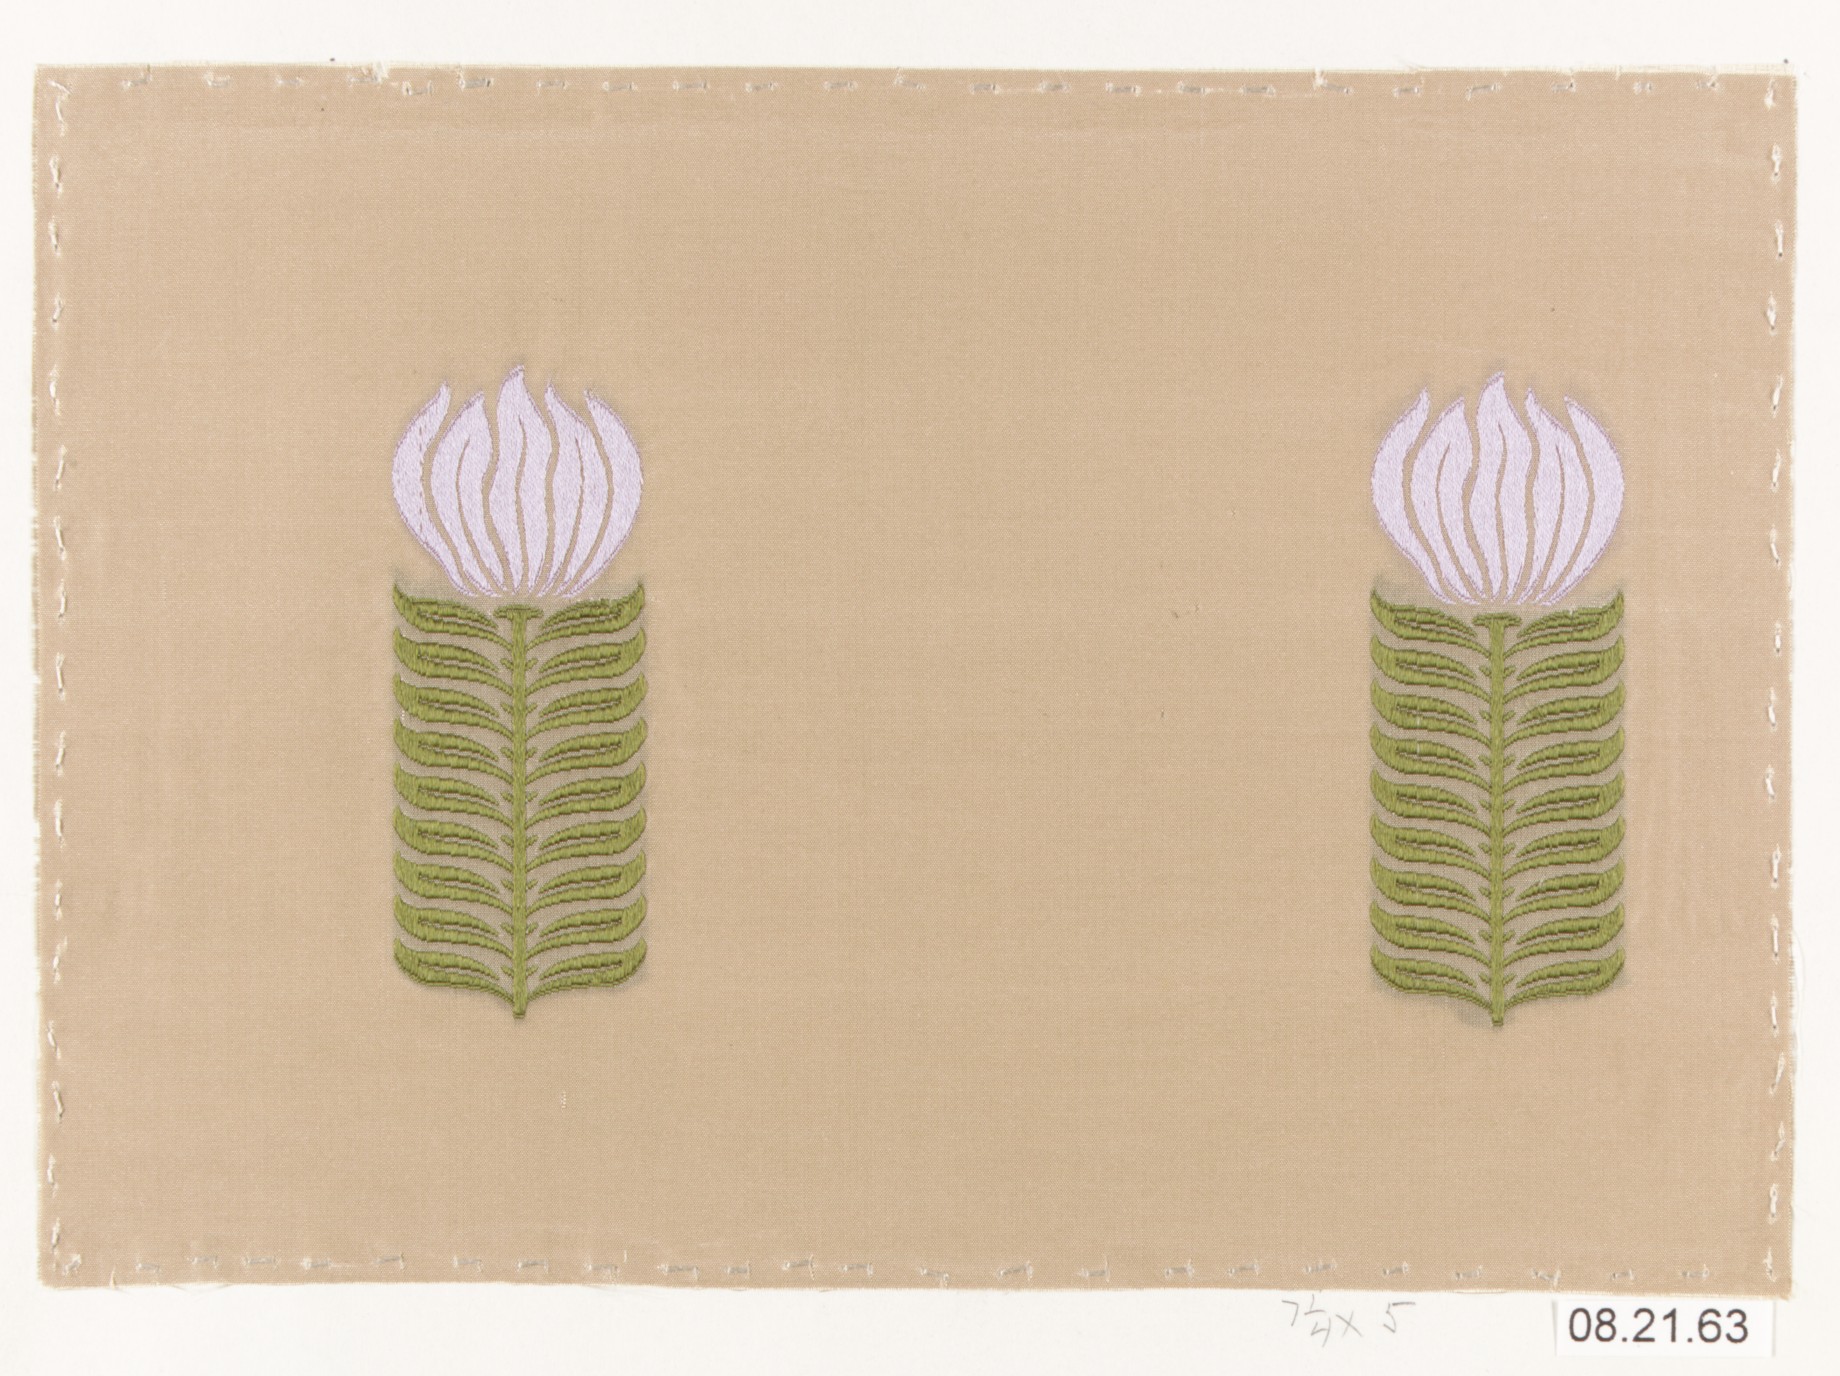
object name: textile sample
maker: Anonymous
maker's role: designer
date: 1900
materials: silk